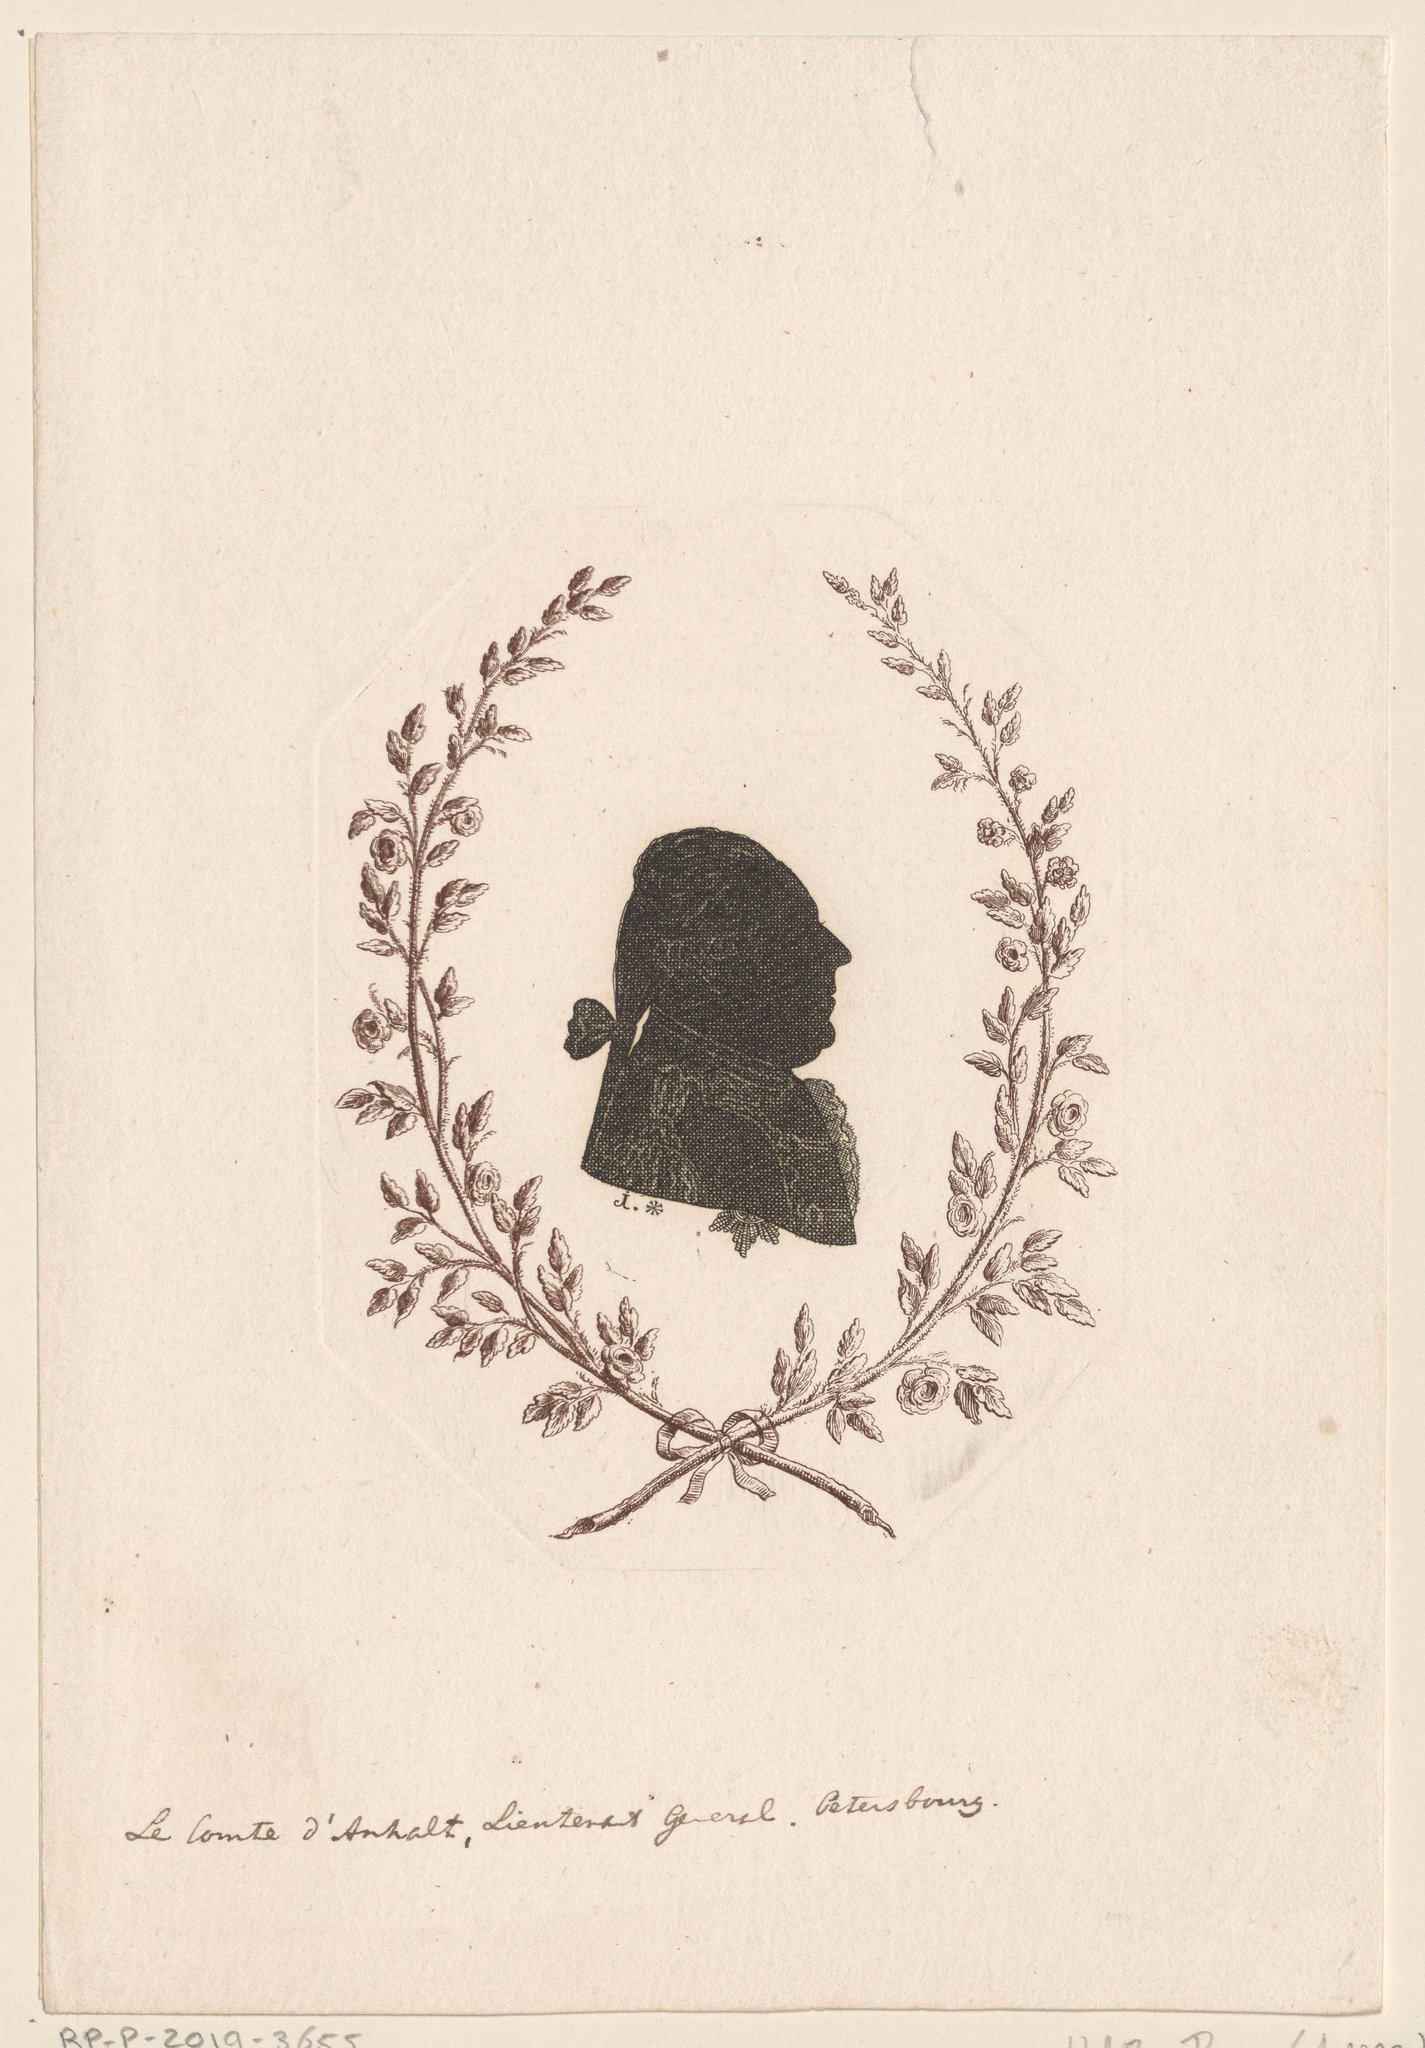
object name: print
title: Silhouetportret van graaf Friedrich von Anhalt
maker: Anonymous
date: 1783-1800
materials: paper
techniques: engraving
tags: earl, historical persons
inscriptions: inscription: ‘Le Comte d'Anhalt, Lieutenant General. Petersbourg.’, monogram: ‘JJ [of JL]’